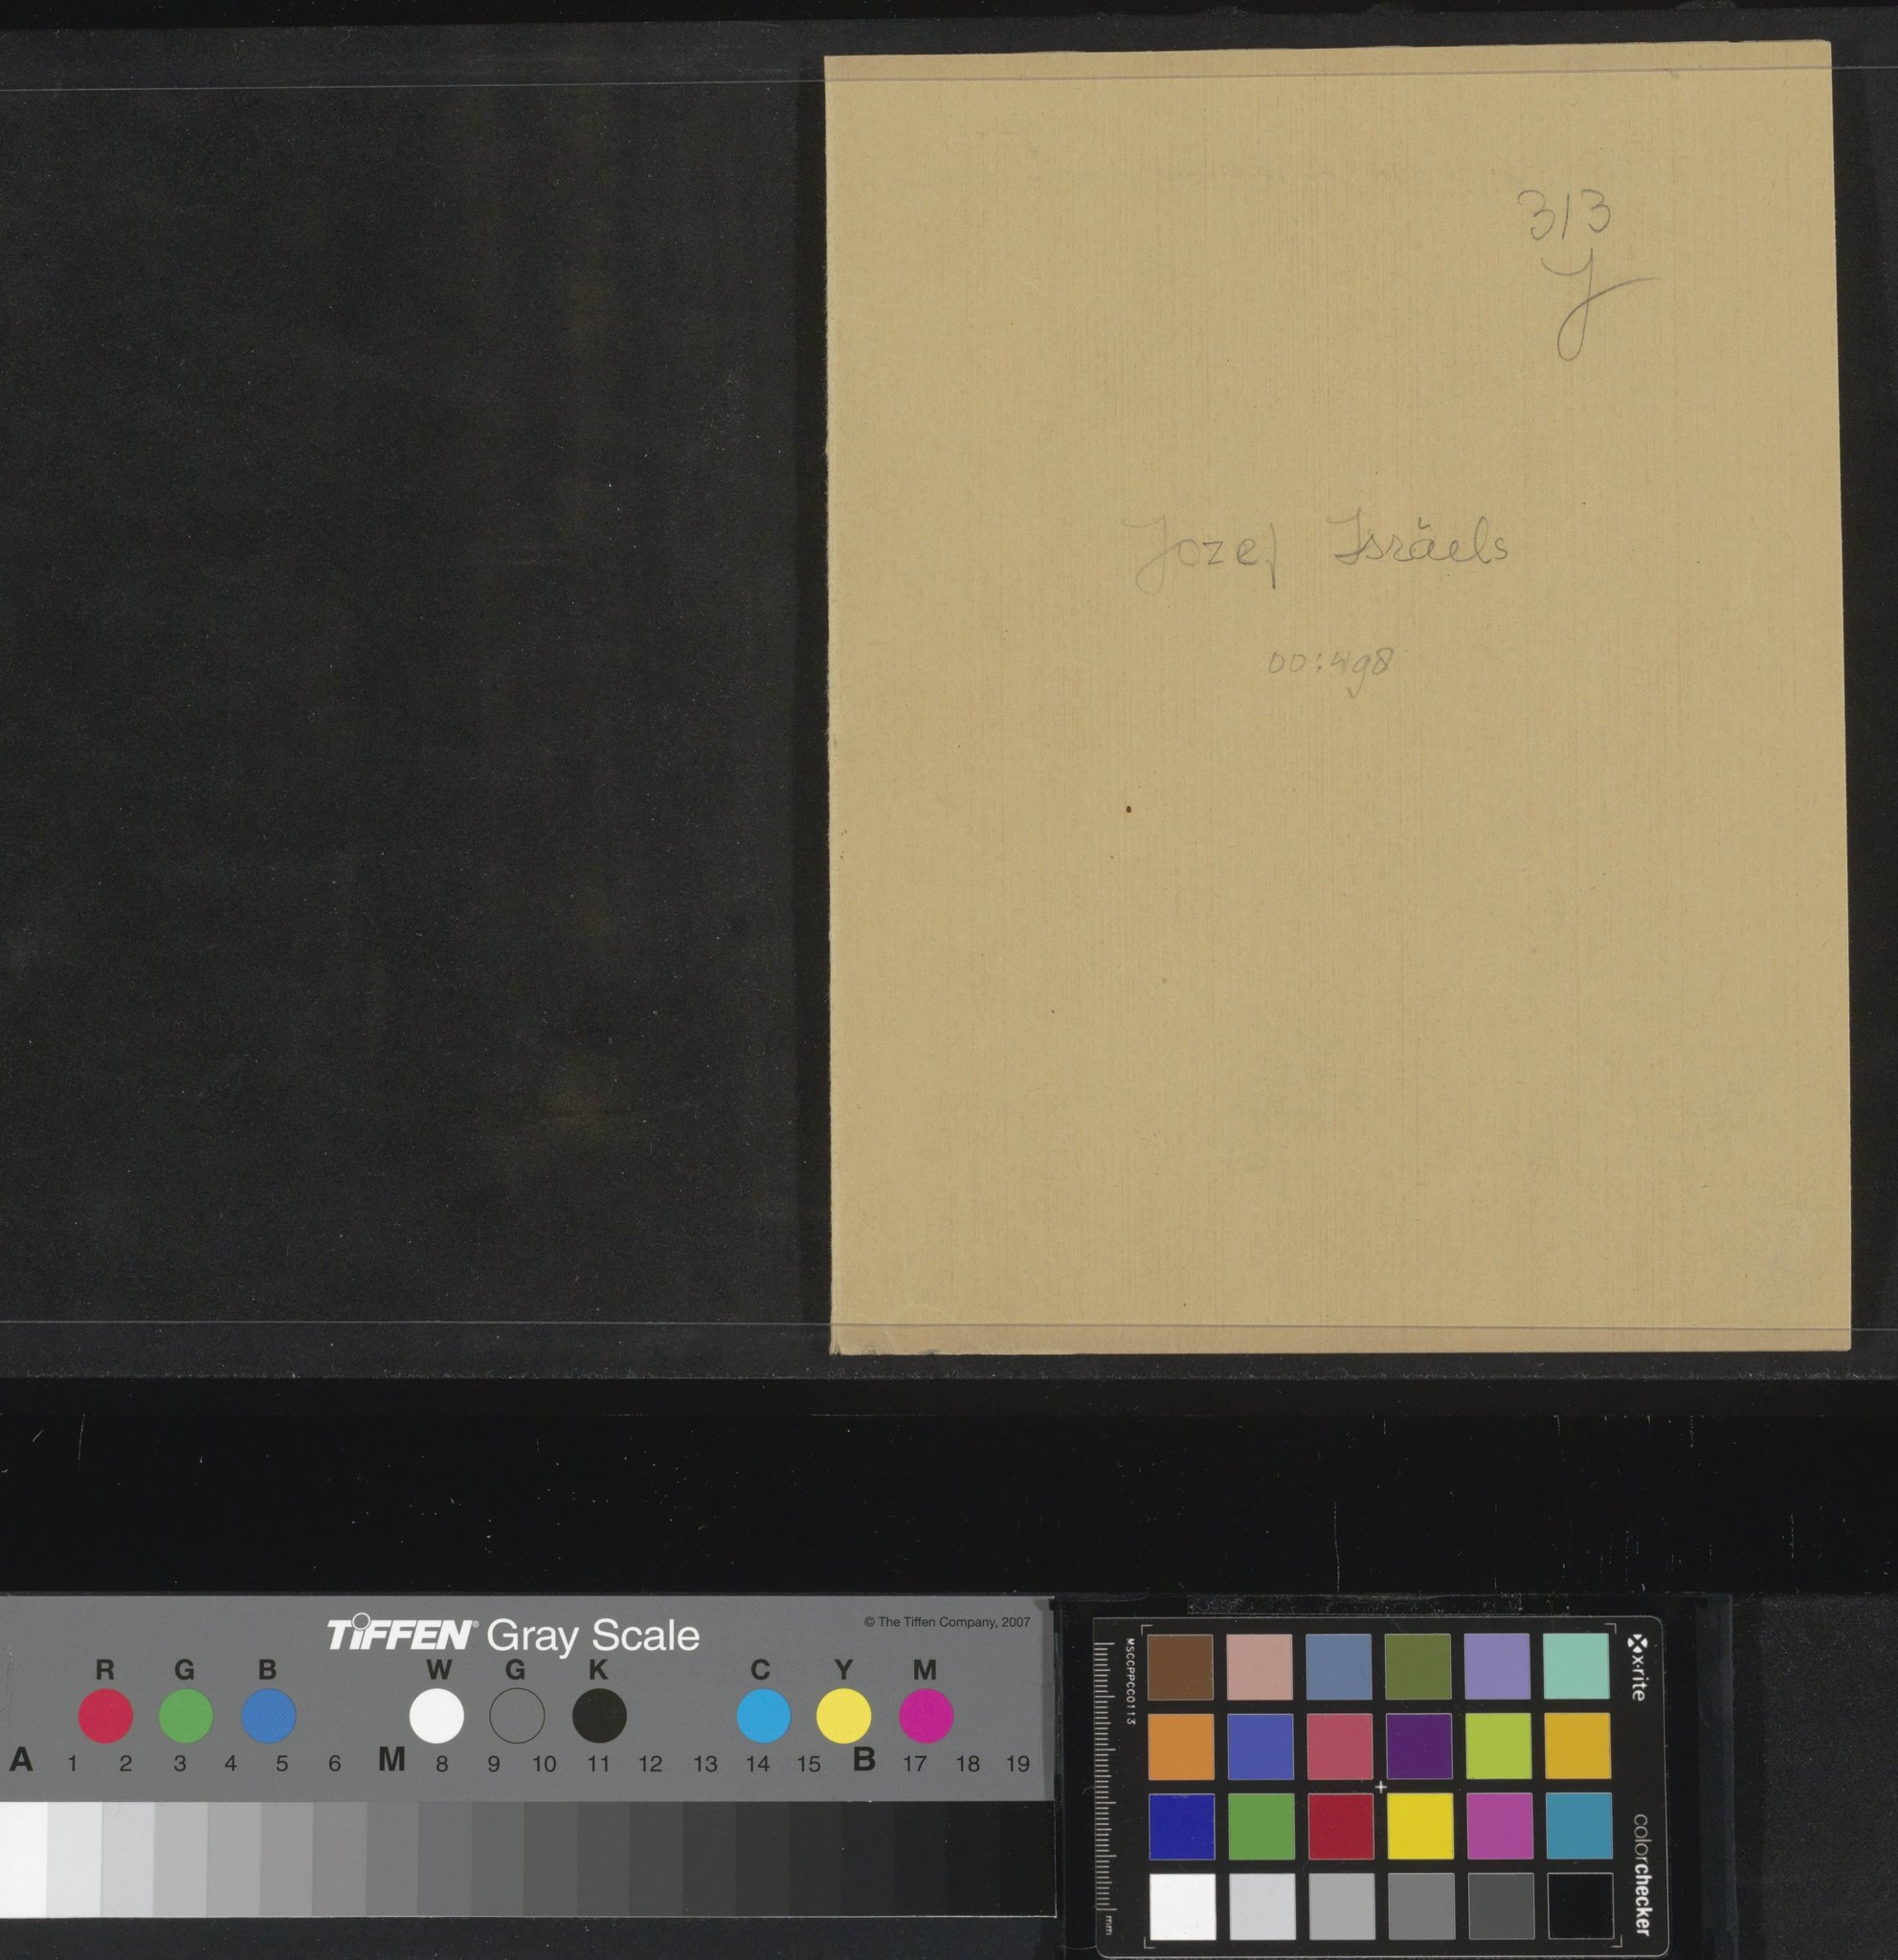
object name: sketchbook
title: Schetsboek met 16 bladen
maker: jozef israëls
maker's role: draughtsman, painter, print maker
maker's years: 1824-1911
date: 1834-1911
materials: cardboard, paper, pencil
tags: head (human), anatomy (non-medical), landscapes (+ landscape with figures, staffage)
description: De volgende bladen uit het schetsboek zijn blanco: 1(V) t/m 4(V), 8(V) en 11(R).